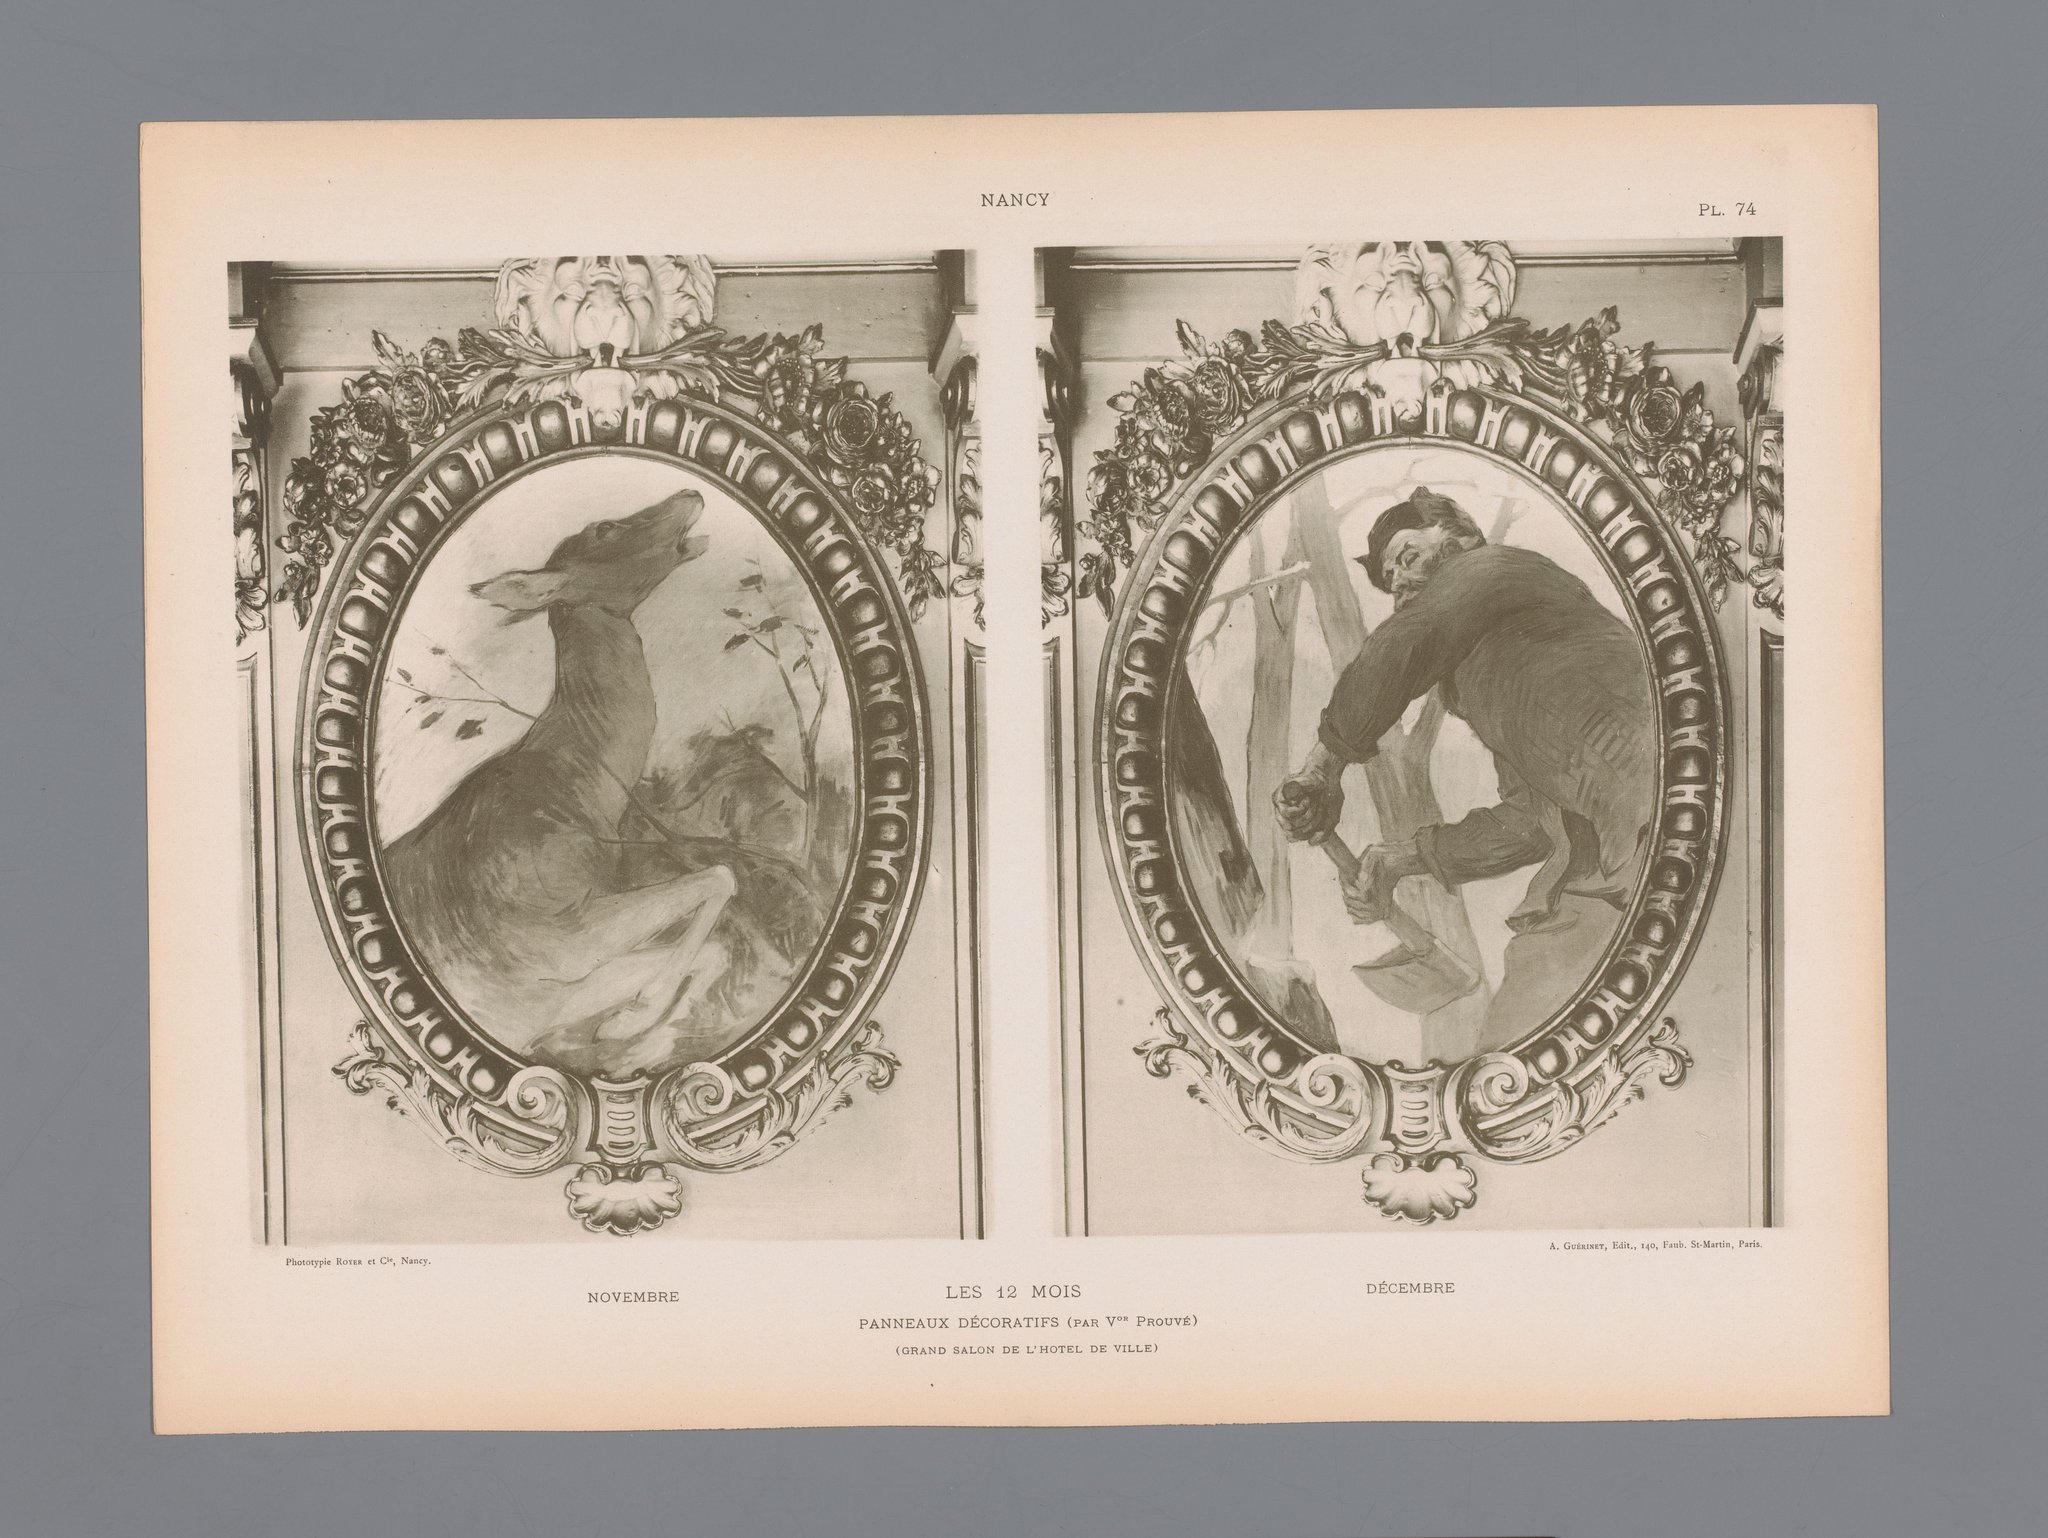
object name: photomechanical print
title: Twee panelen met representaties van november en december in het stadhuis te Nancy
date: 1891-1896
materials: paper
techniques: photograph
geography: nancy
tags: townhall, painting (including book-illumination, miniature-painting), november ~ other concepts, december ~ other concepts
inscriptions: inscription: ‘Les 12 Mois/ panneaux décoratifs (par Vor Prouvé)’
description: Deze prent maakt deel uit van een omslag met 103 prenten op 101 bladen en een titelblad.